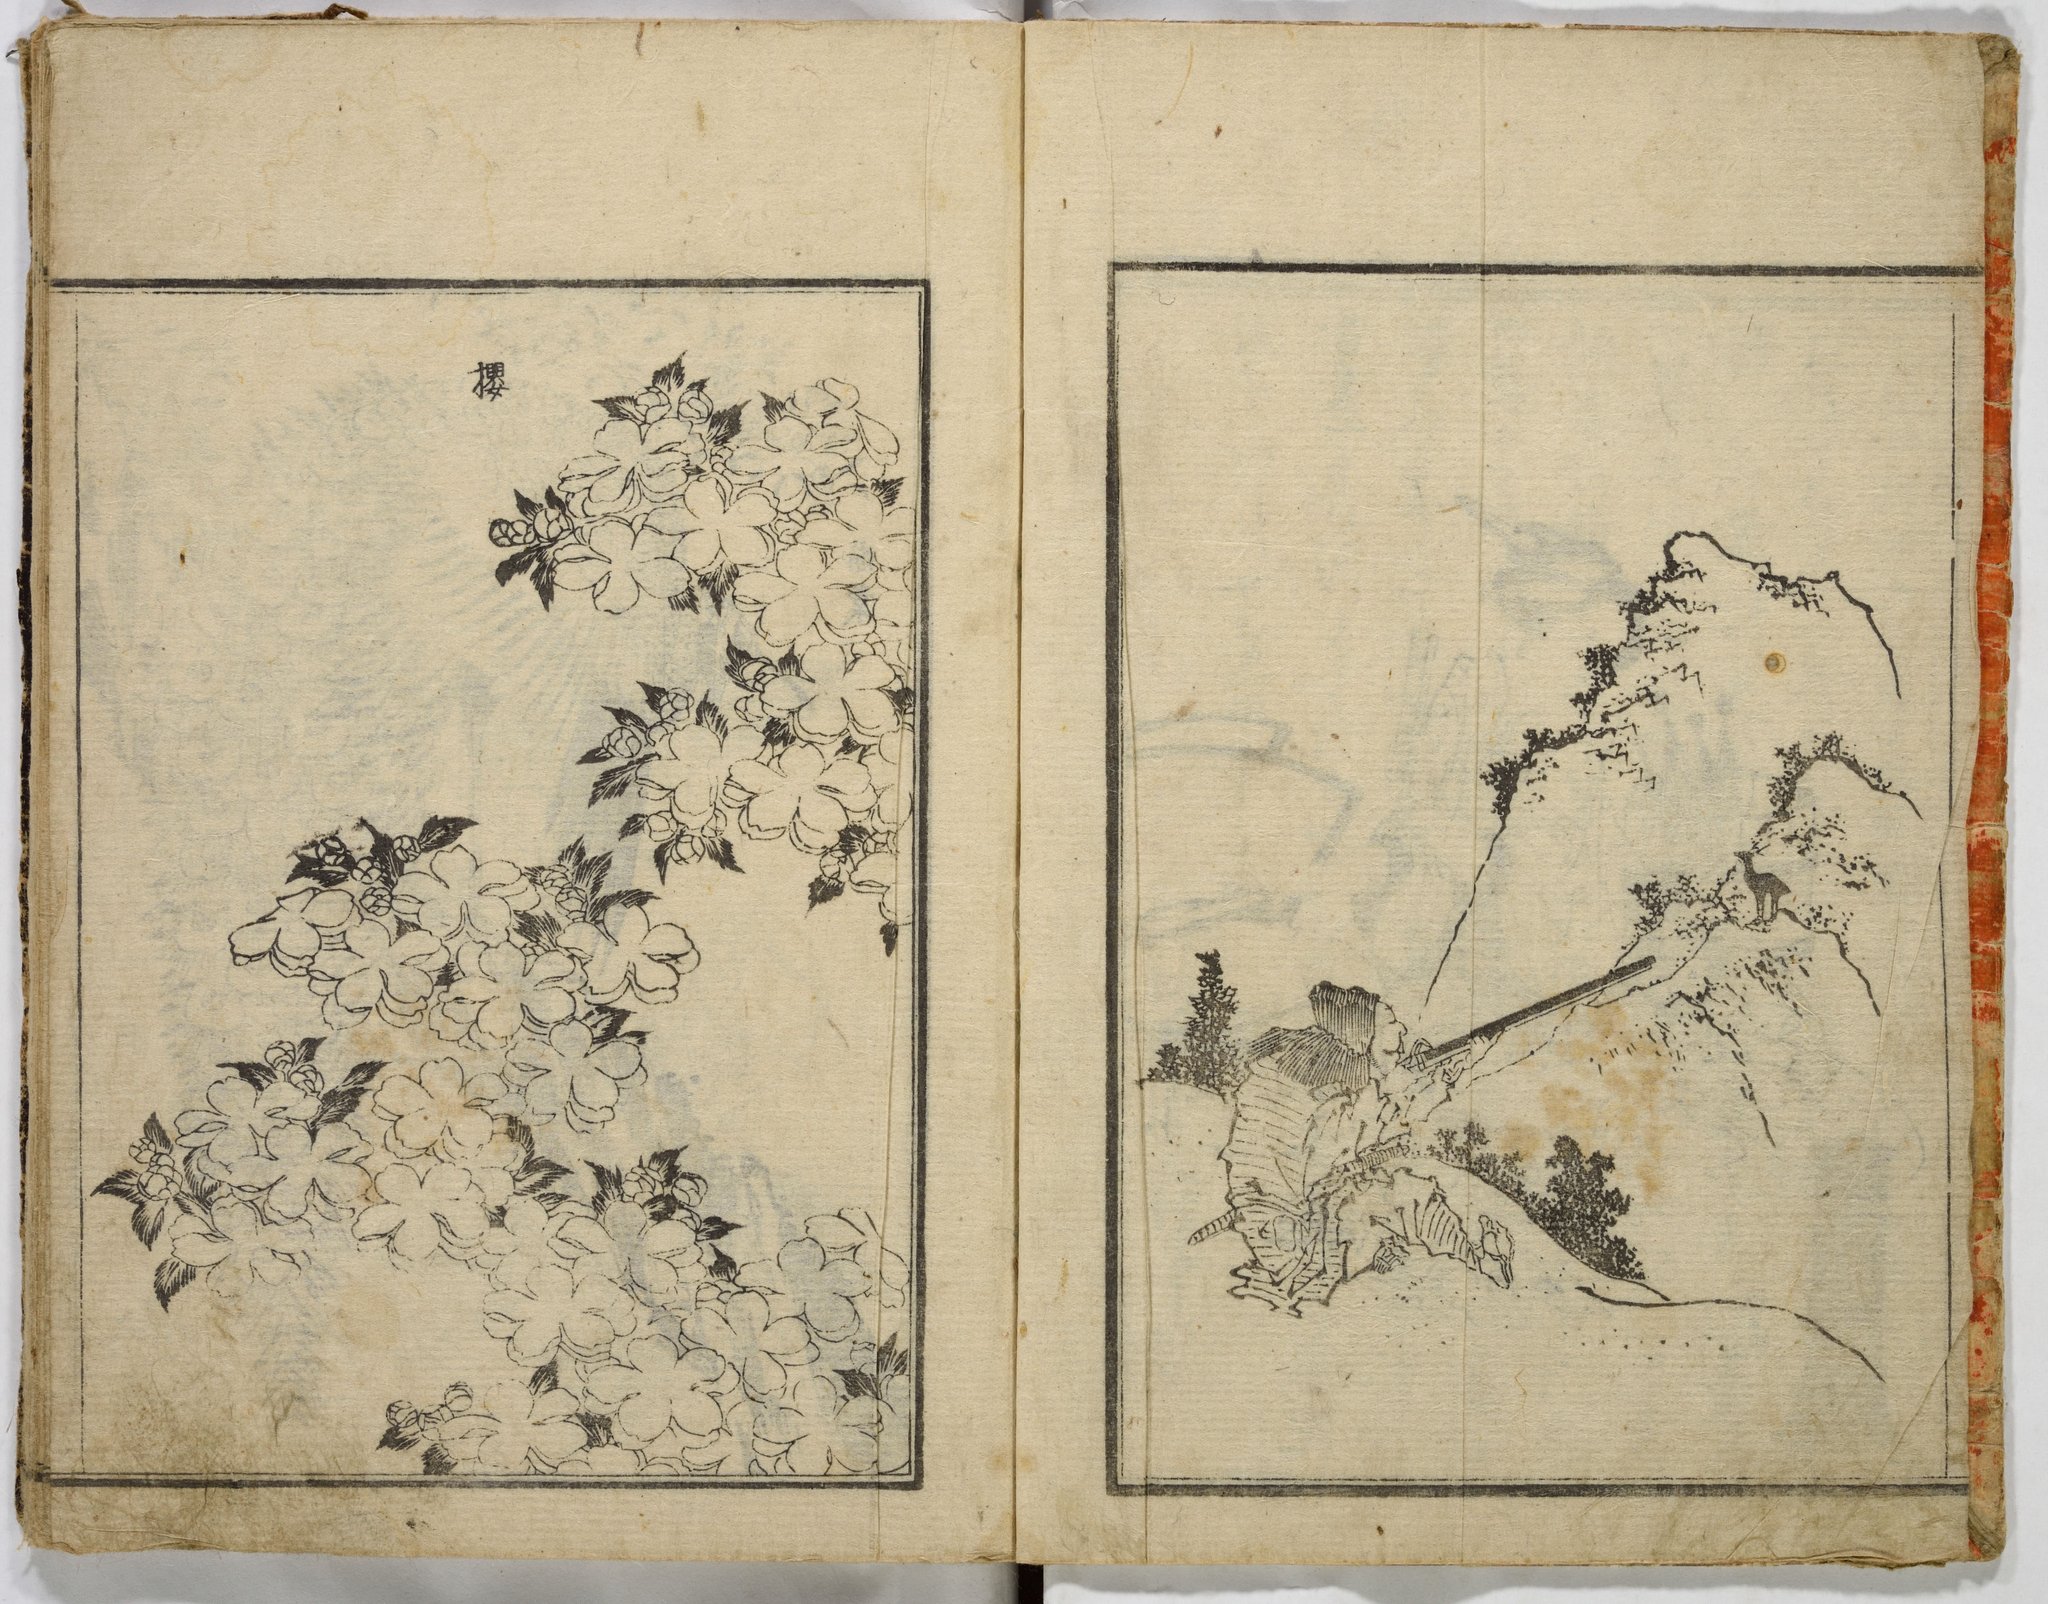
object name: illustrated book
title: Random Sketches by Hokusai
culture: japanese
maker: katsushika hokusai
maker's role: artist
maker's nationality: japanese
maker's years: 1760-1849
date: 1834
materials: ink, paper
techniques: woodblock print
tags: hunting,deer,flowers